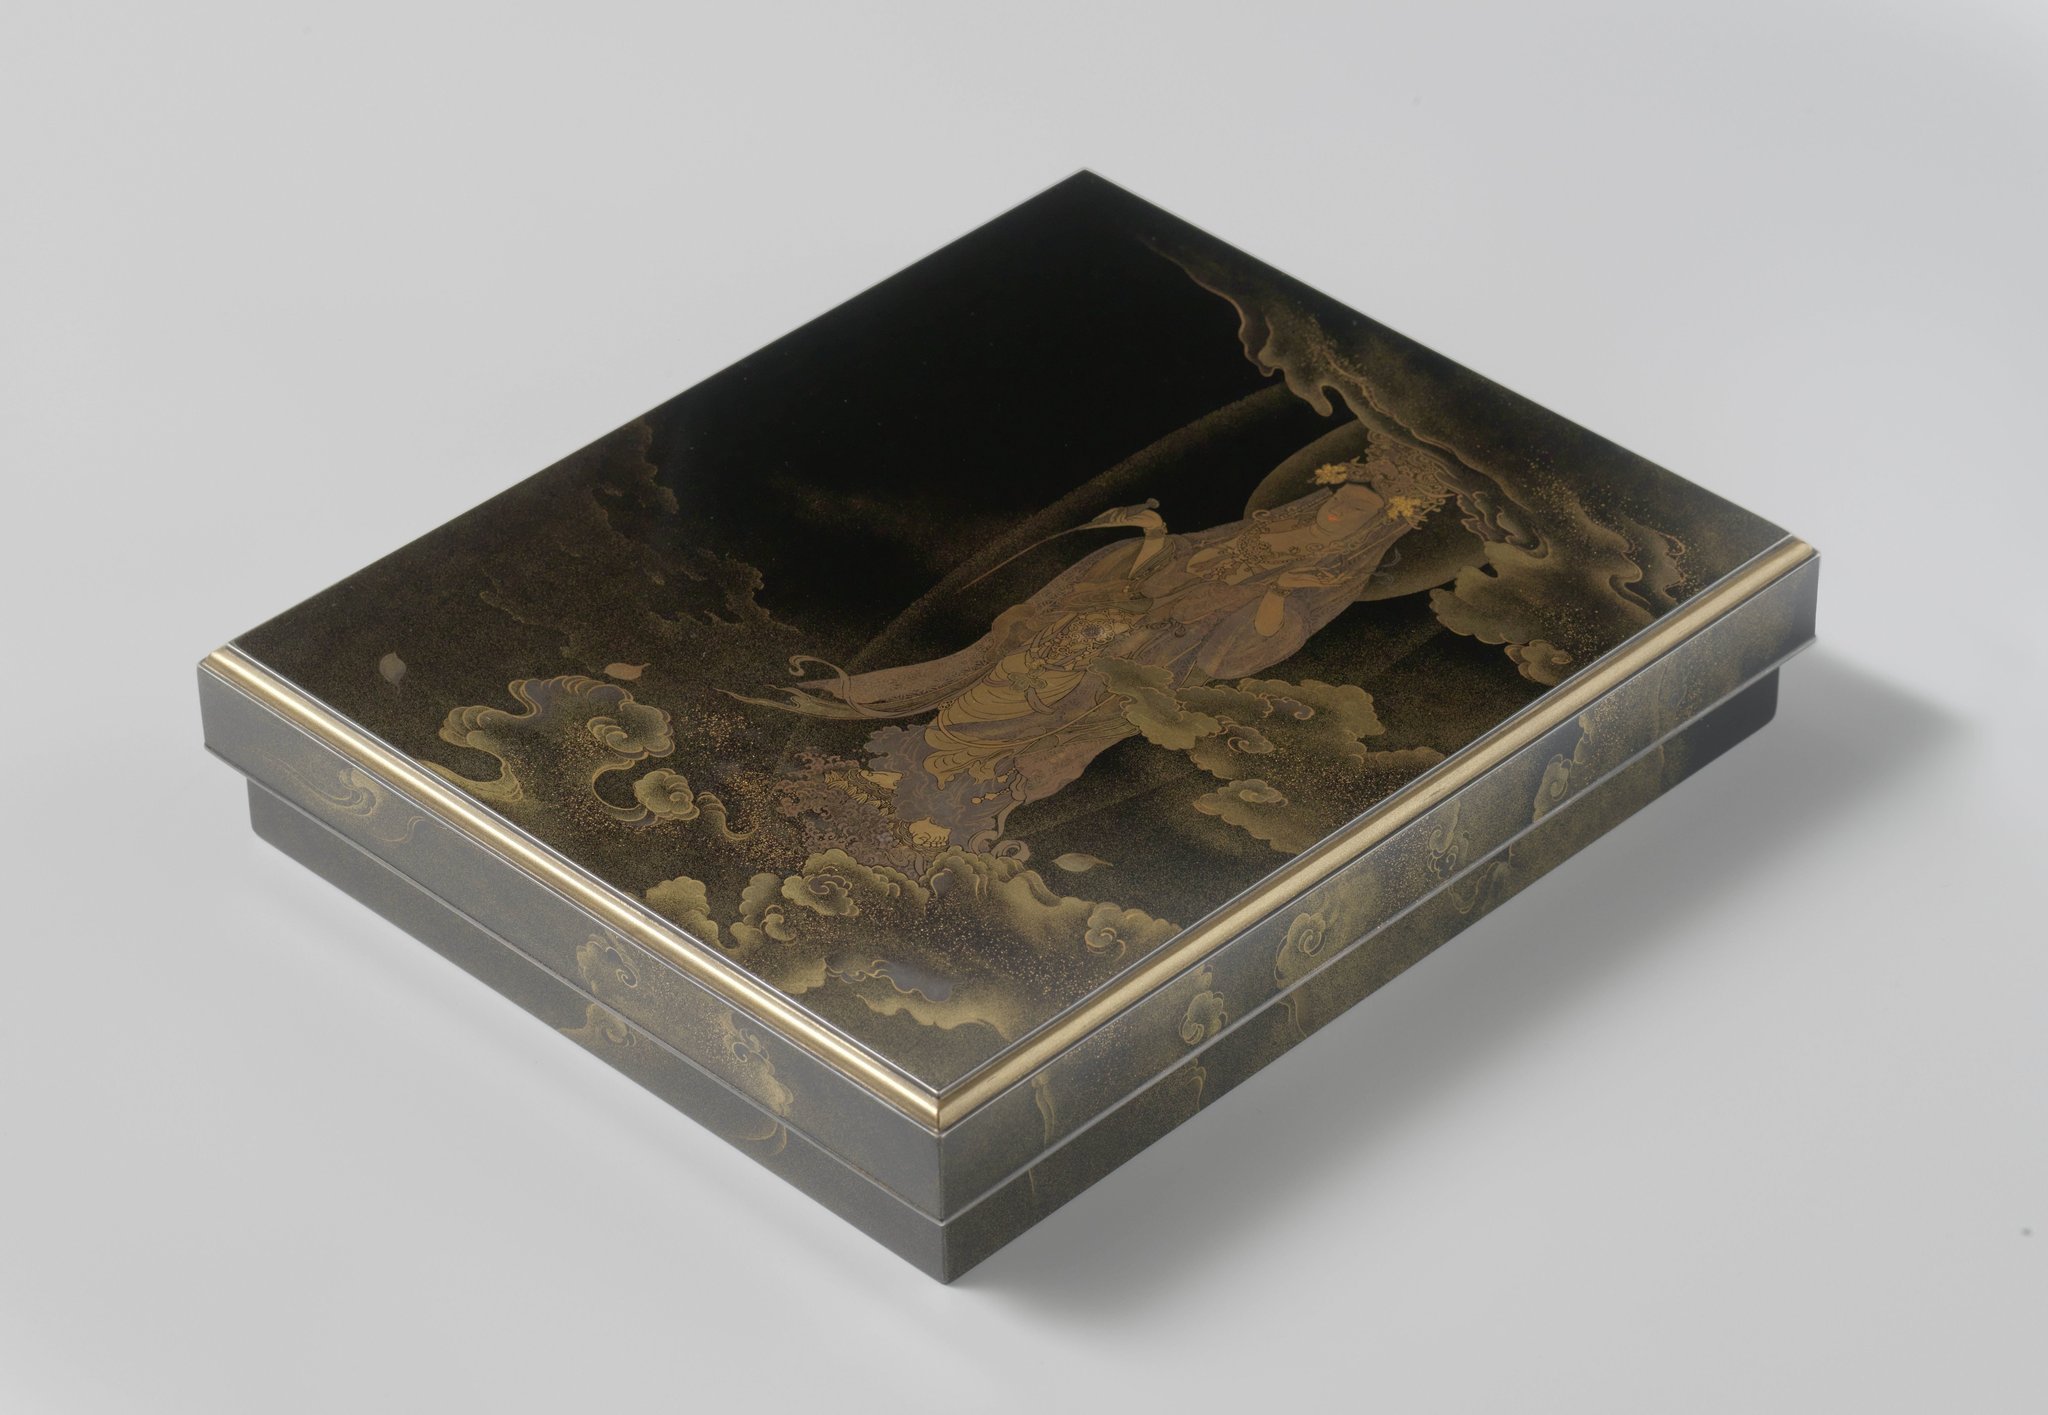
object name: schrijfdoos, schrijfcassette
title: Writing box with Kannon with the Willow Branch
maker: shirayama shosai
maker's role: lacquerer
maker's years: 1853-1923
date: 1890-1900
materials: gold, lacquer, silver, wood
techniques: hiramakie, maki-e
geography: japan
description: On lotus slippers, the Buddhist goddess Kannon descends from the clouds onto Lotus Paradise Island. This lotus paradise is depicted on the inside of the box. Kannon is welcomed by the music of flute and drum, as can be seen on the silver water-dropper. Writing paper can be kept under the tray containing the inkstone and the waterdropper.